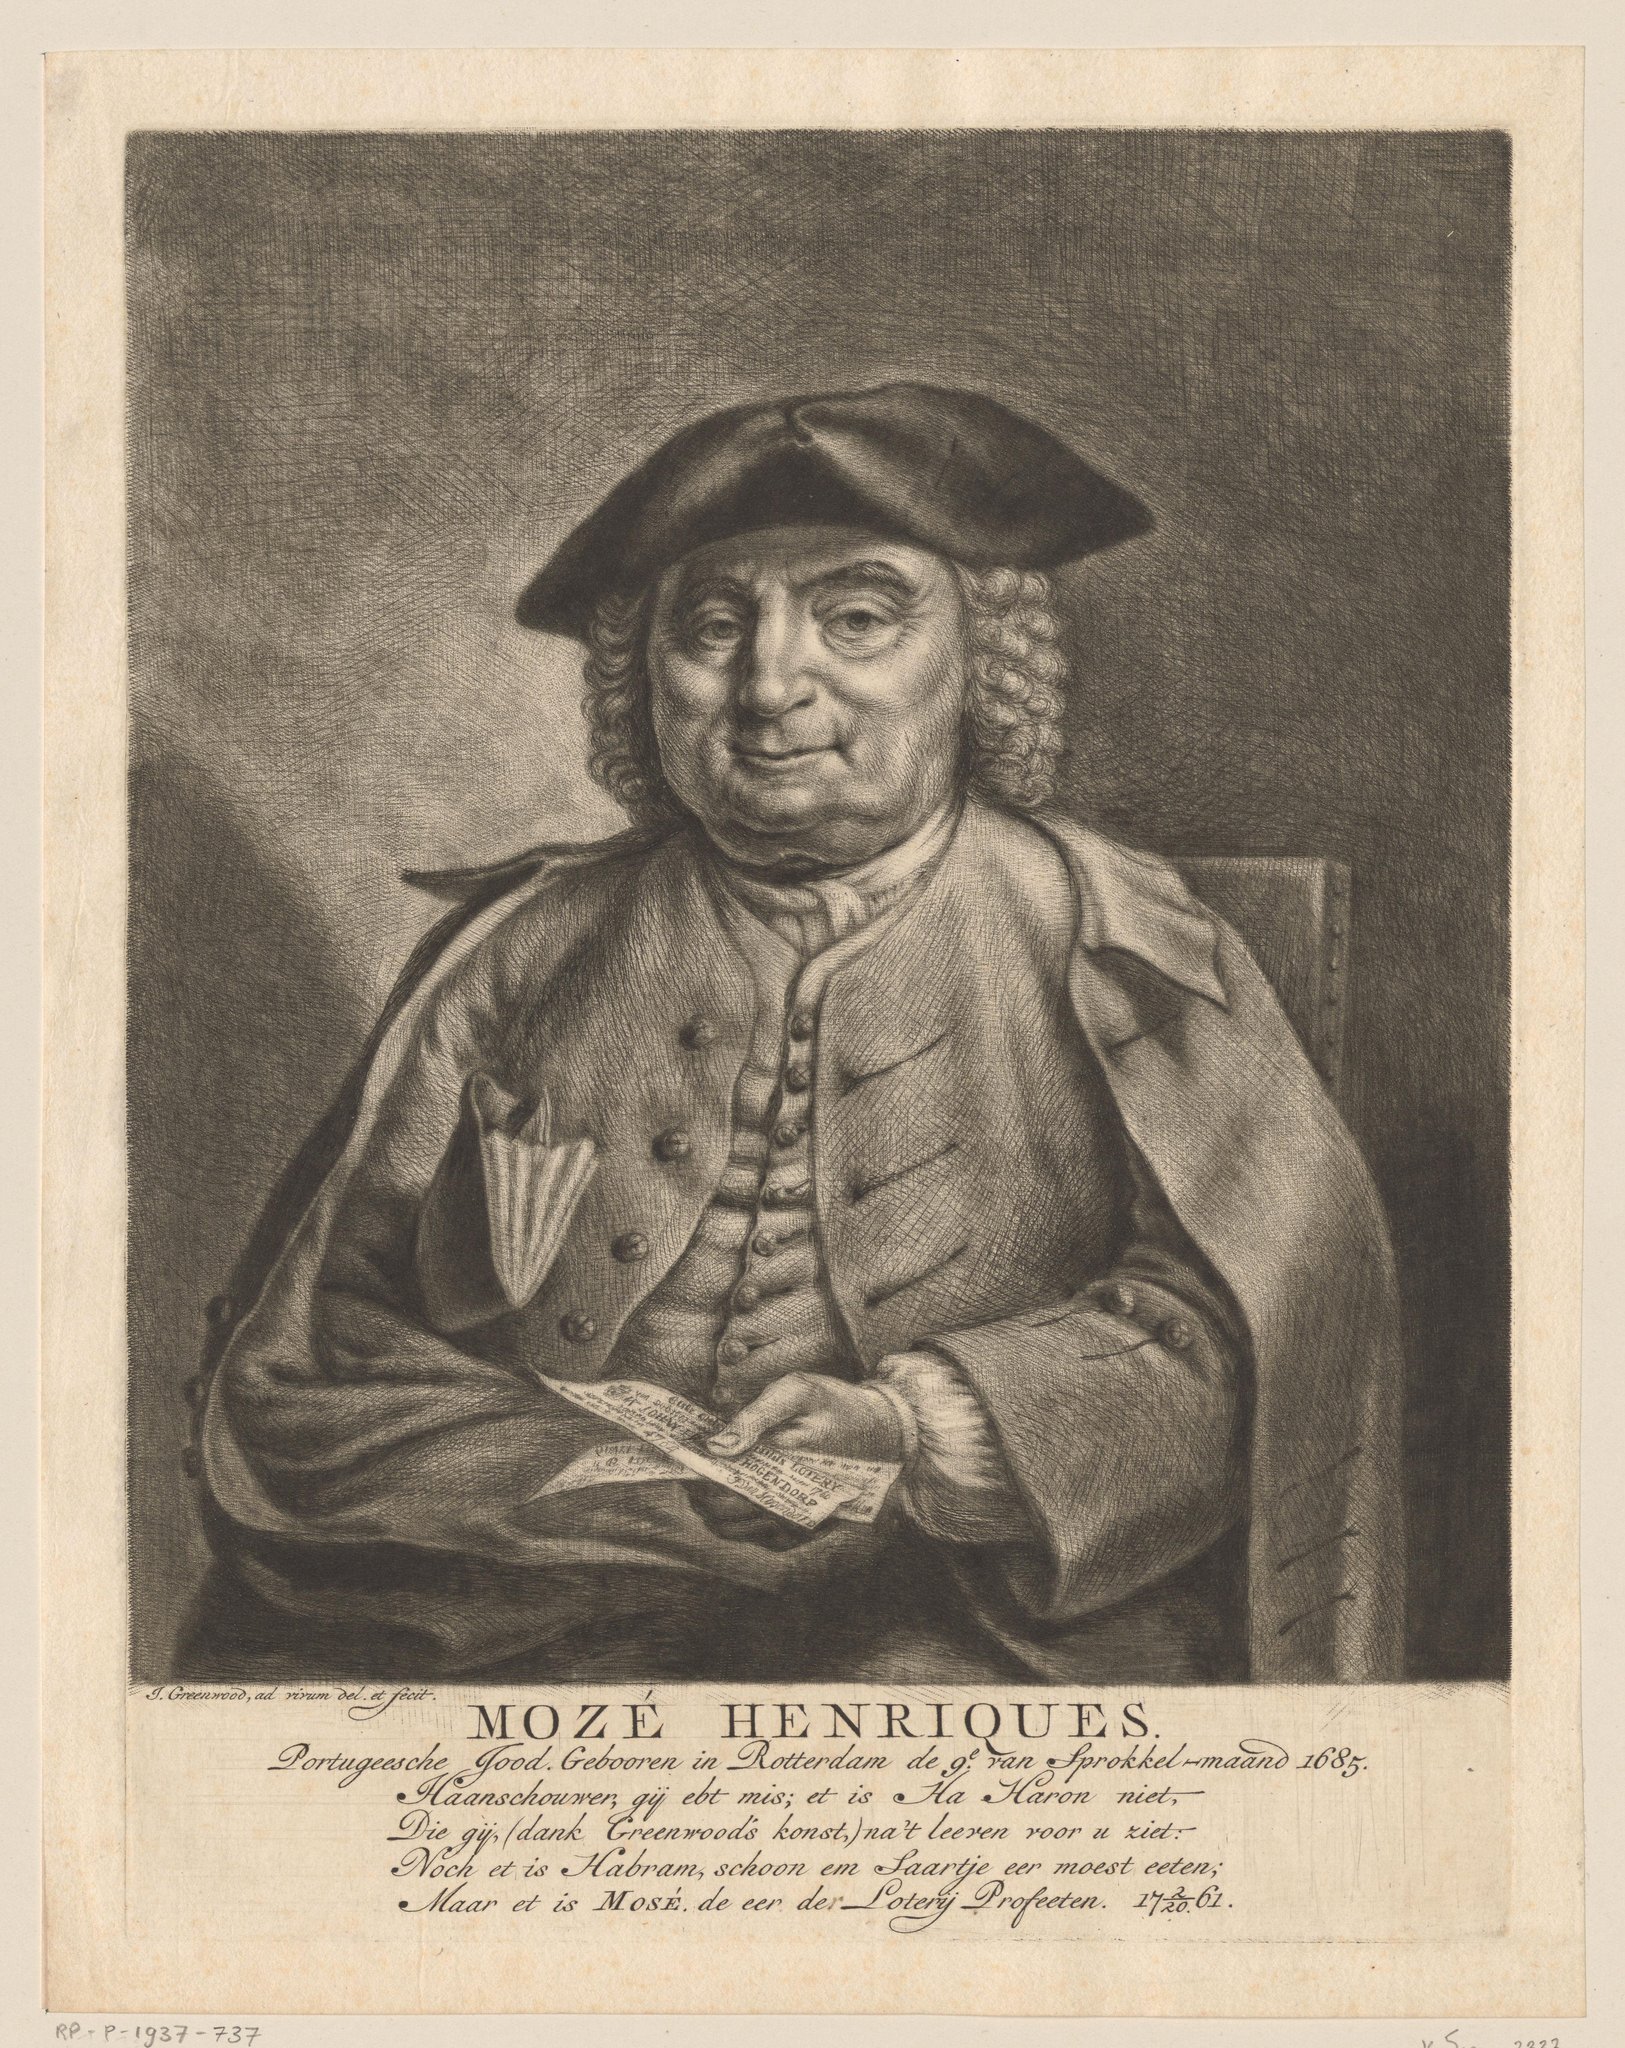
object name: print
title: Portret van Mozé Henriquez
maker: john greenwood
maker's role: auctioneer, draughtsman, print maker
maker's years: 1727-1792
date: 1761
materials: paper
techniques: engraving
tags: rotterdam, raffle, lottery, historical persons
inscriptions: collector's mark: Lugt 2228, collector's mark: Lugt 2760